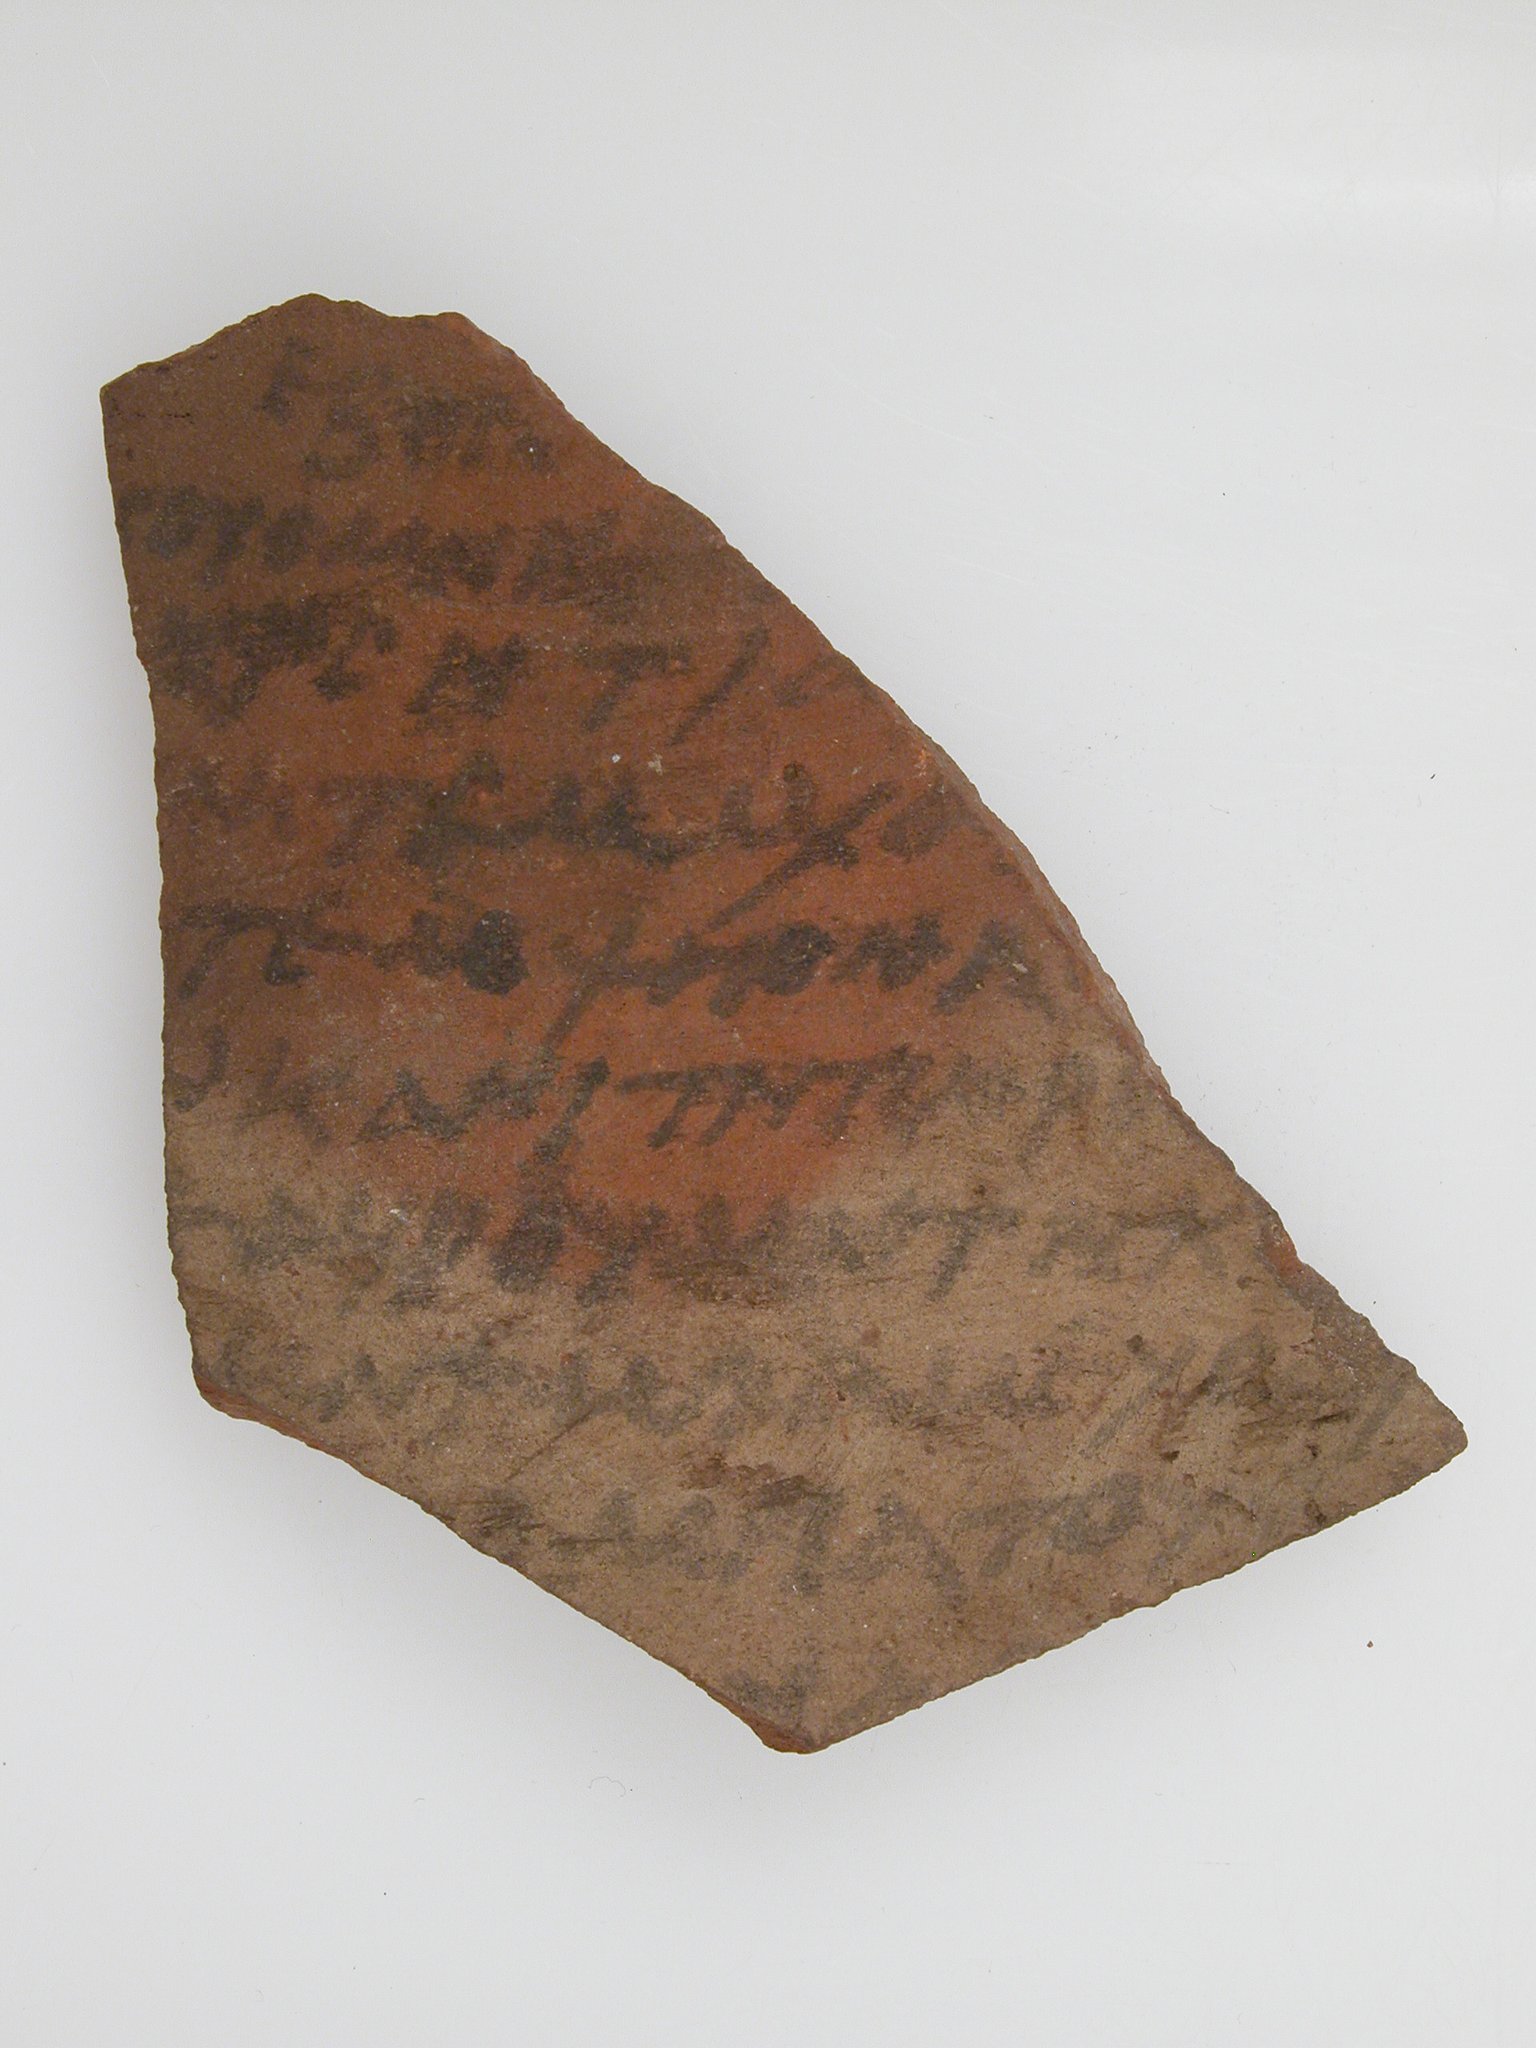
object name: ostrakon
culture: coptic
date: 601-700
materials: ink, pottery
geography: egypt